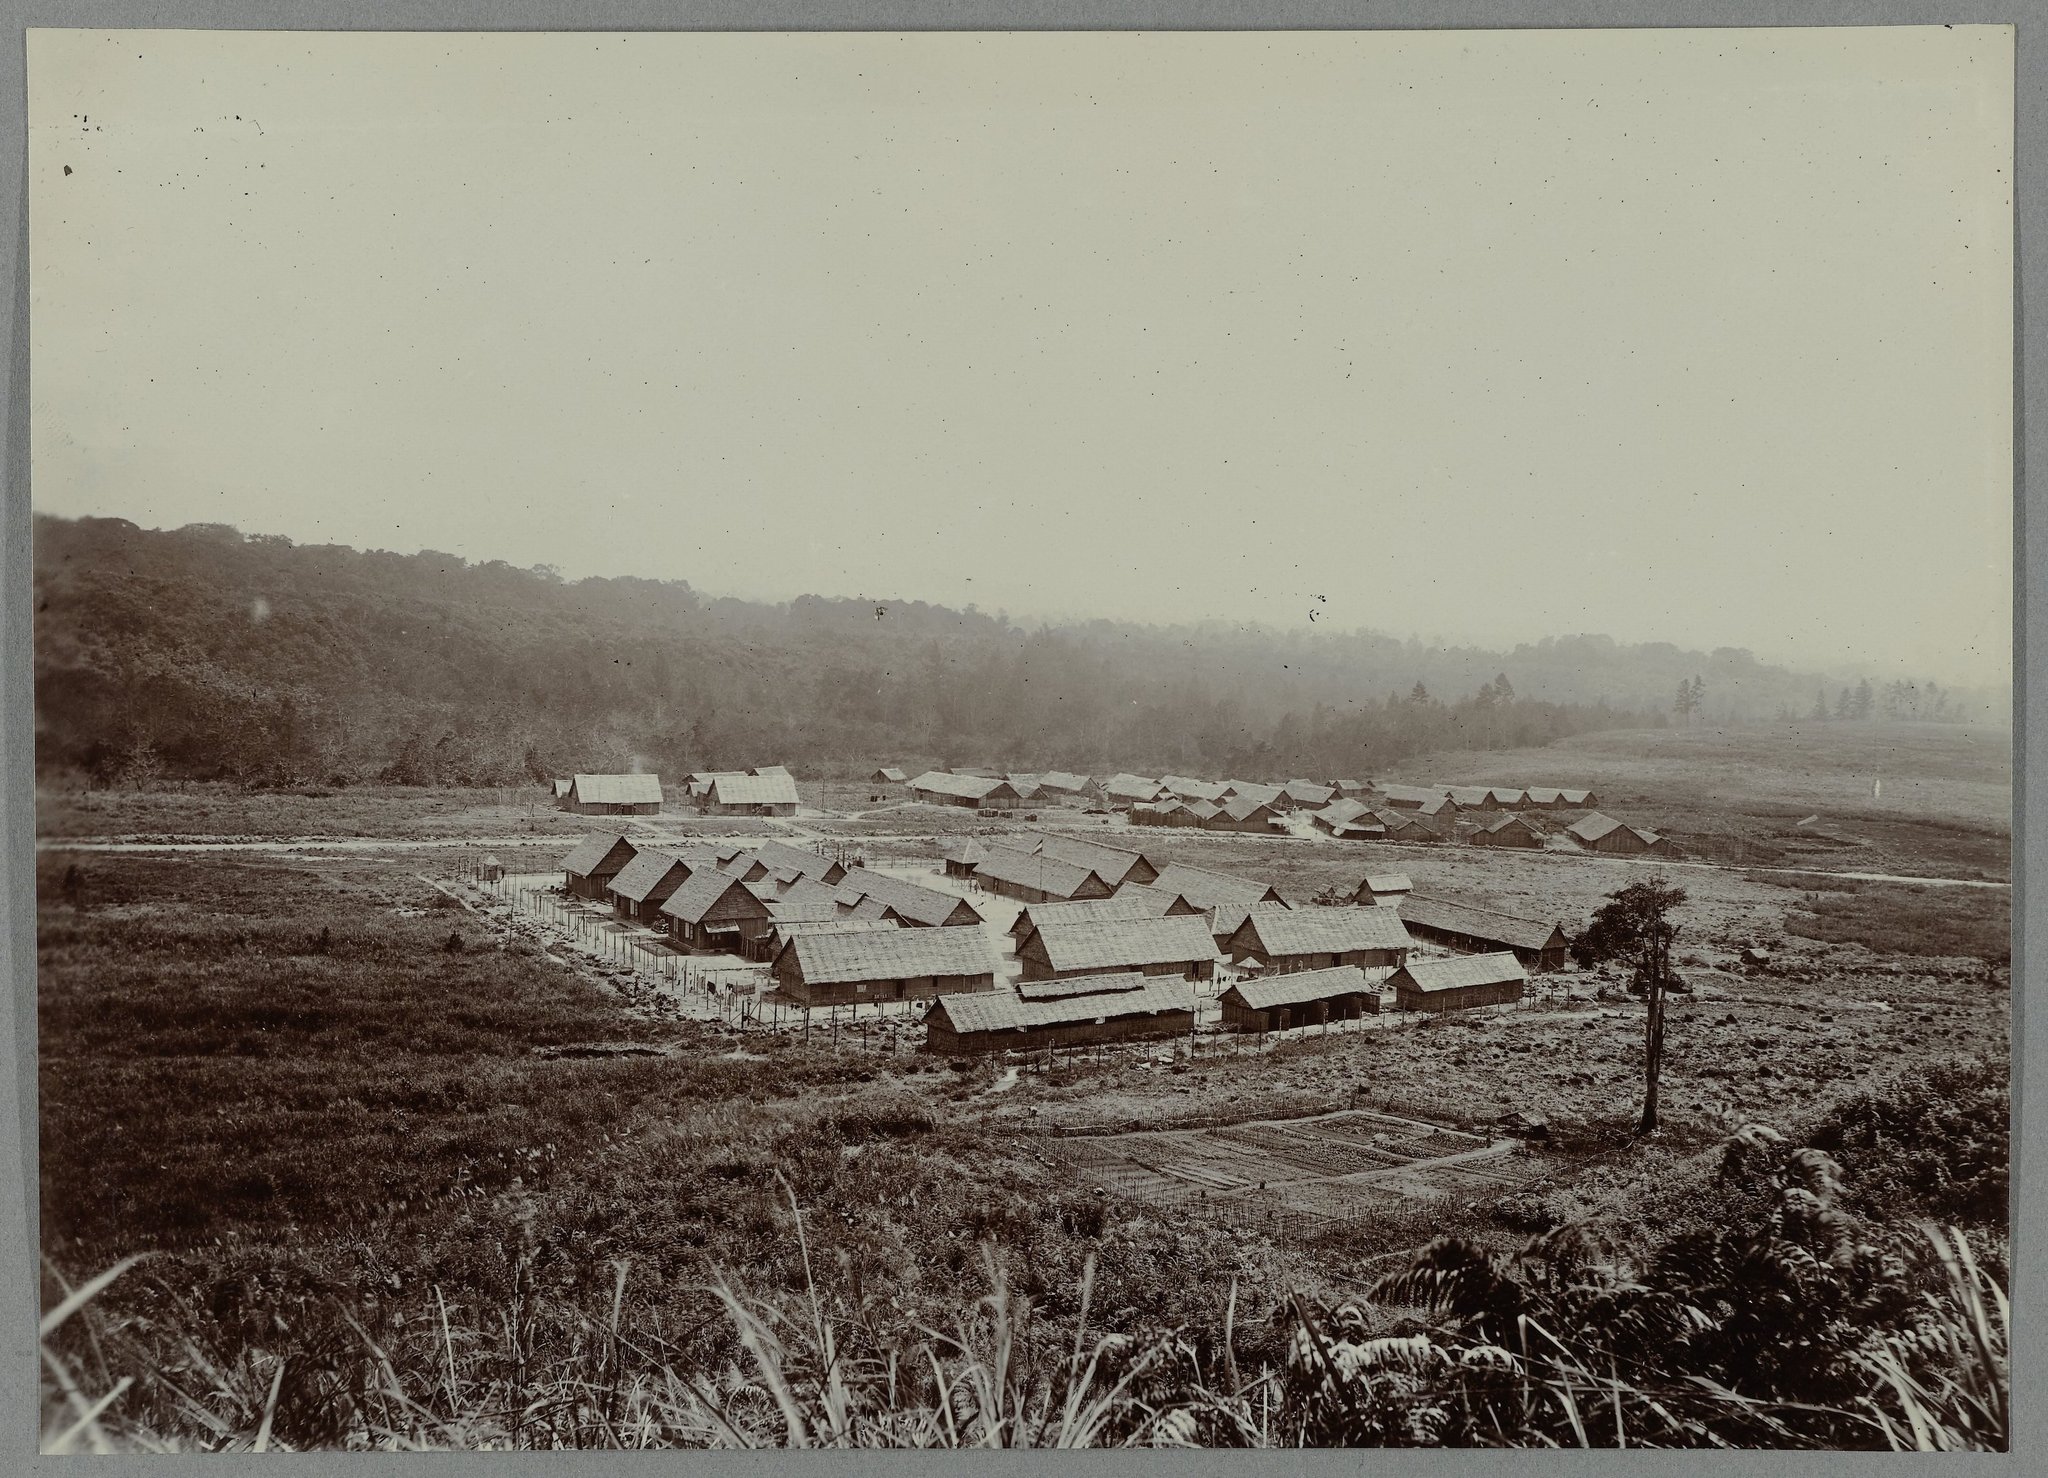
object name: photograph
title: Bivak Lampahan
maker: Anonymous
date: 1903-1913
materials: photographic support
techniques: photography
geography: north sumatra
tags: arnhem, albertus dominicus laman trip, traffic by road or path with motor-vehicle, landscapes in tropical and sub-tropical regions, village, road, path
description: Na de expedities naar de Gajo- en Alaslanden o.l.v. Van Daalen (eerste tocht in 1901), werd hij in 1903 belast met voorbereiding van permanente vestiging van Nederlands gezag. Aanleg van een weg van de Noordkust naar het binnenland was hierbij van groot belang. Deze zgn. Gajoweg werd aangelegd tussen 1903 en 1914, van Bireuen aan de kust naar Takinguen aan het bergmeer Danau Lauttawar, totale lente 104 km.